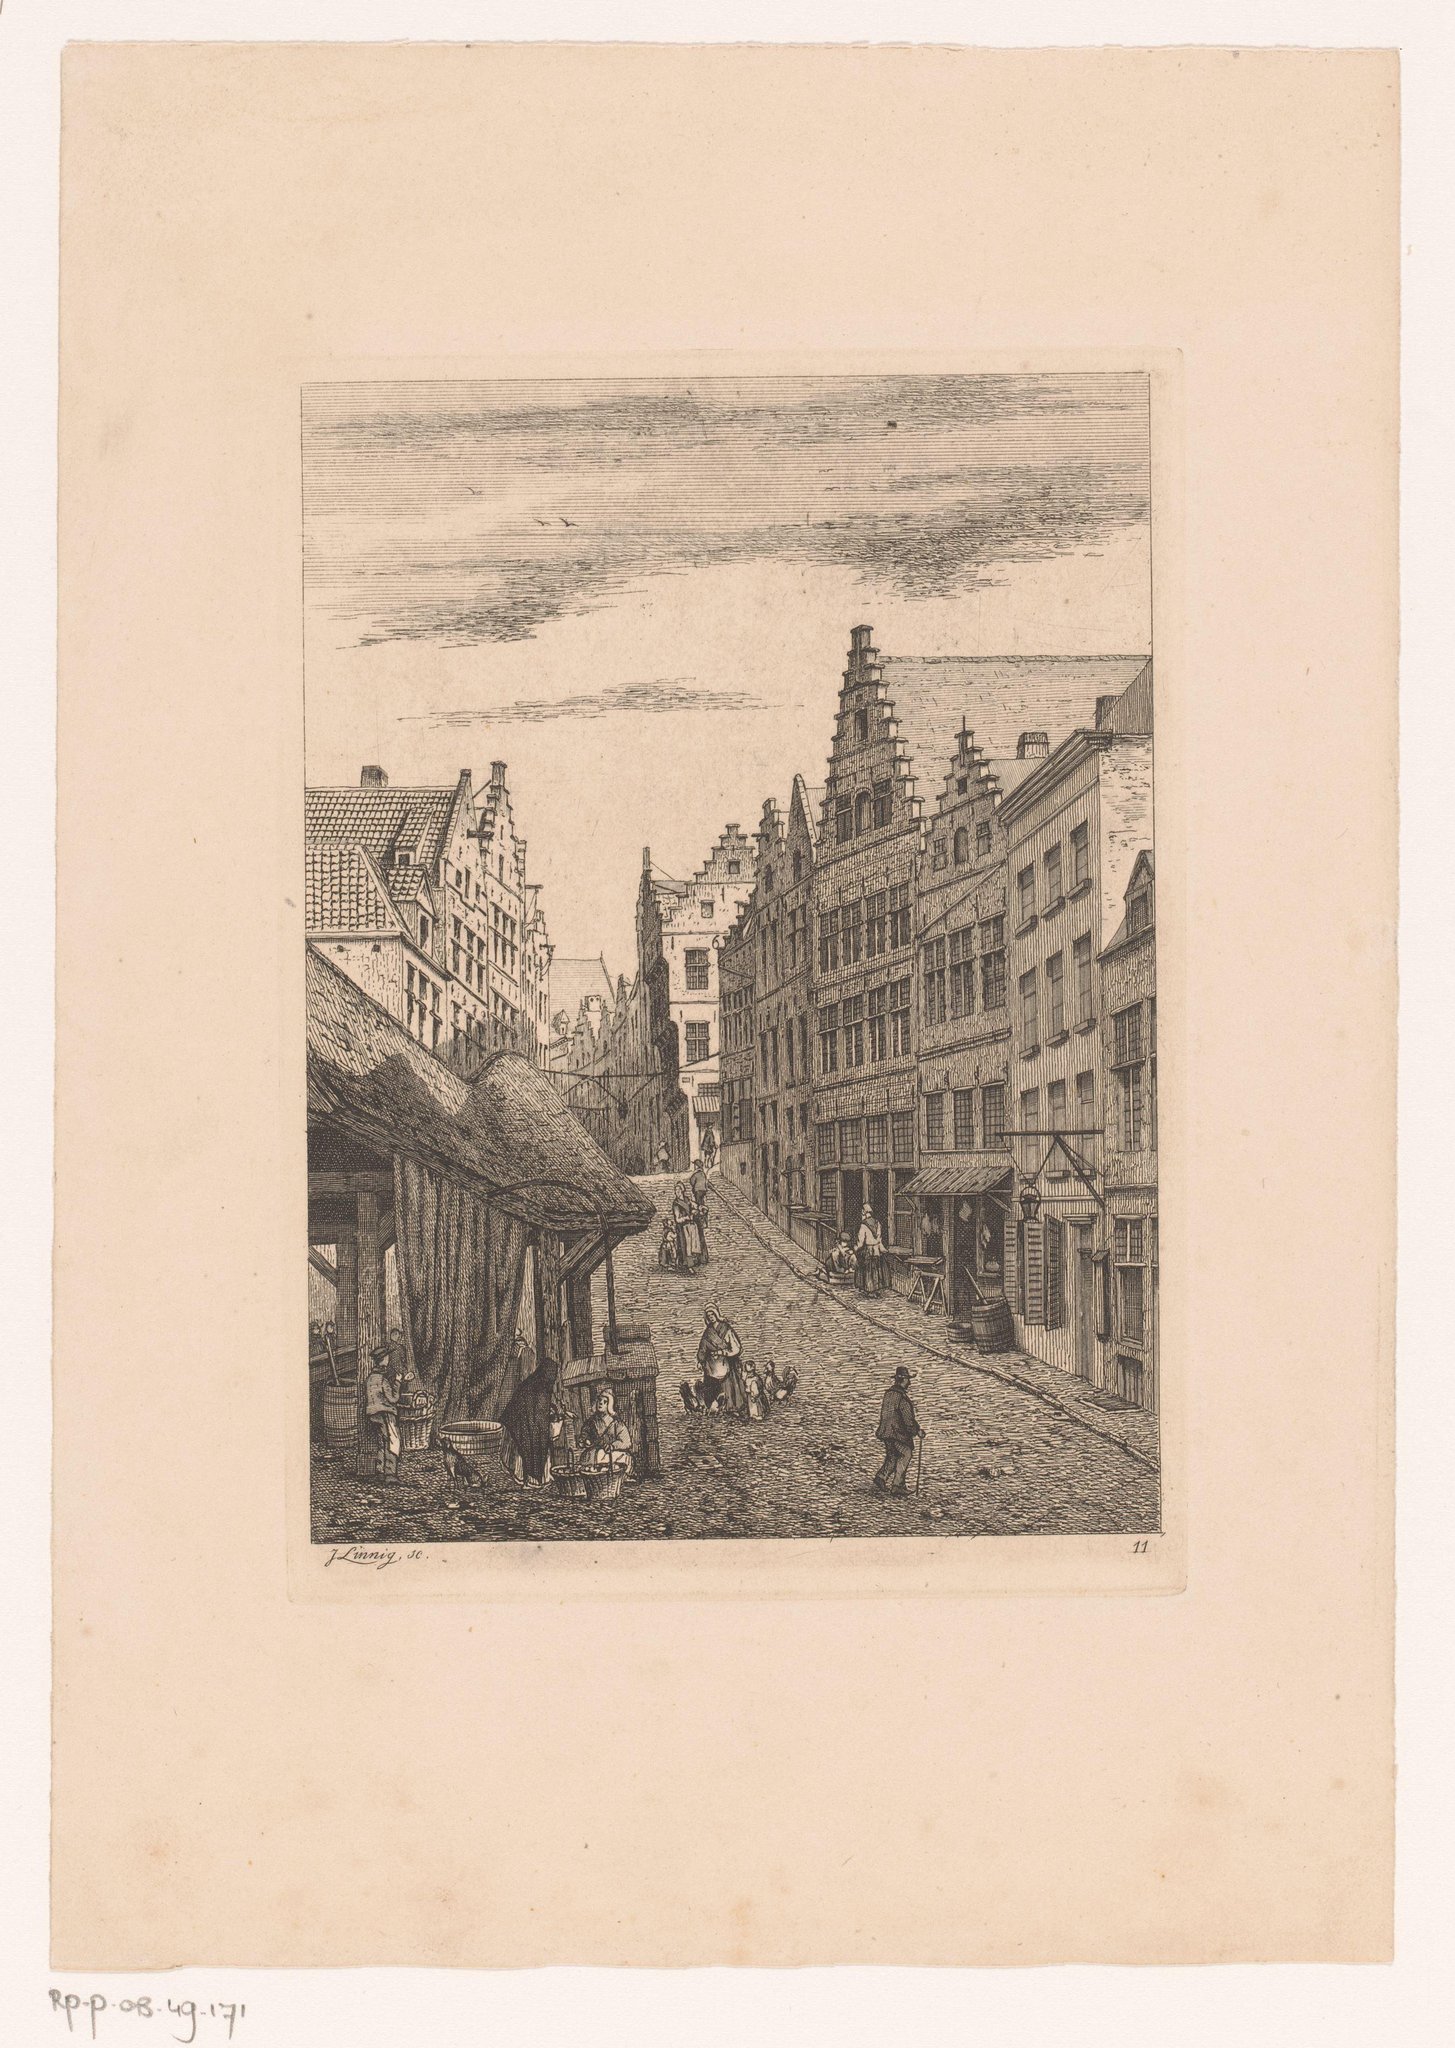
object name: book illustration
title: Gezicht op de Visberg in Antwerpen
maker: jean théodore joseph linnig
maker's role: draughtsman, print maker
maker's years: 1815-1891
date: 1868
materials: paper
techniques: etching, intaglio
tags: sloping street; street with steps or stairs, antwerp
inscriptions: collector's mark: Lugt 2228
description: Prent uit: Mertens, F.H. Album historique de la ville d'Anvers [...]. Antwerpen: J.E. Buschmann, 1868.